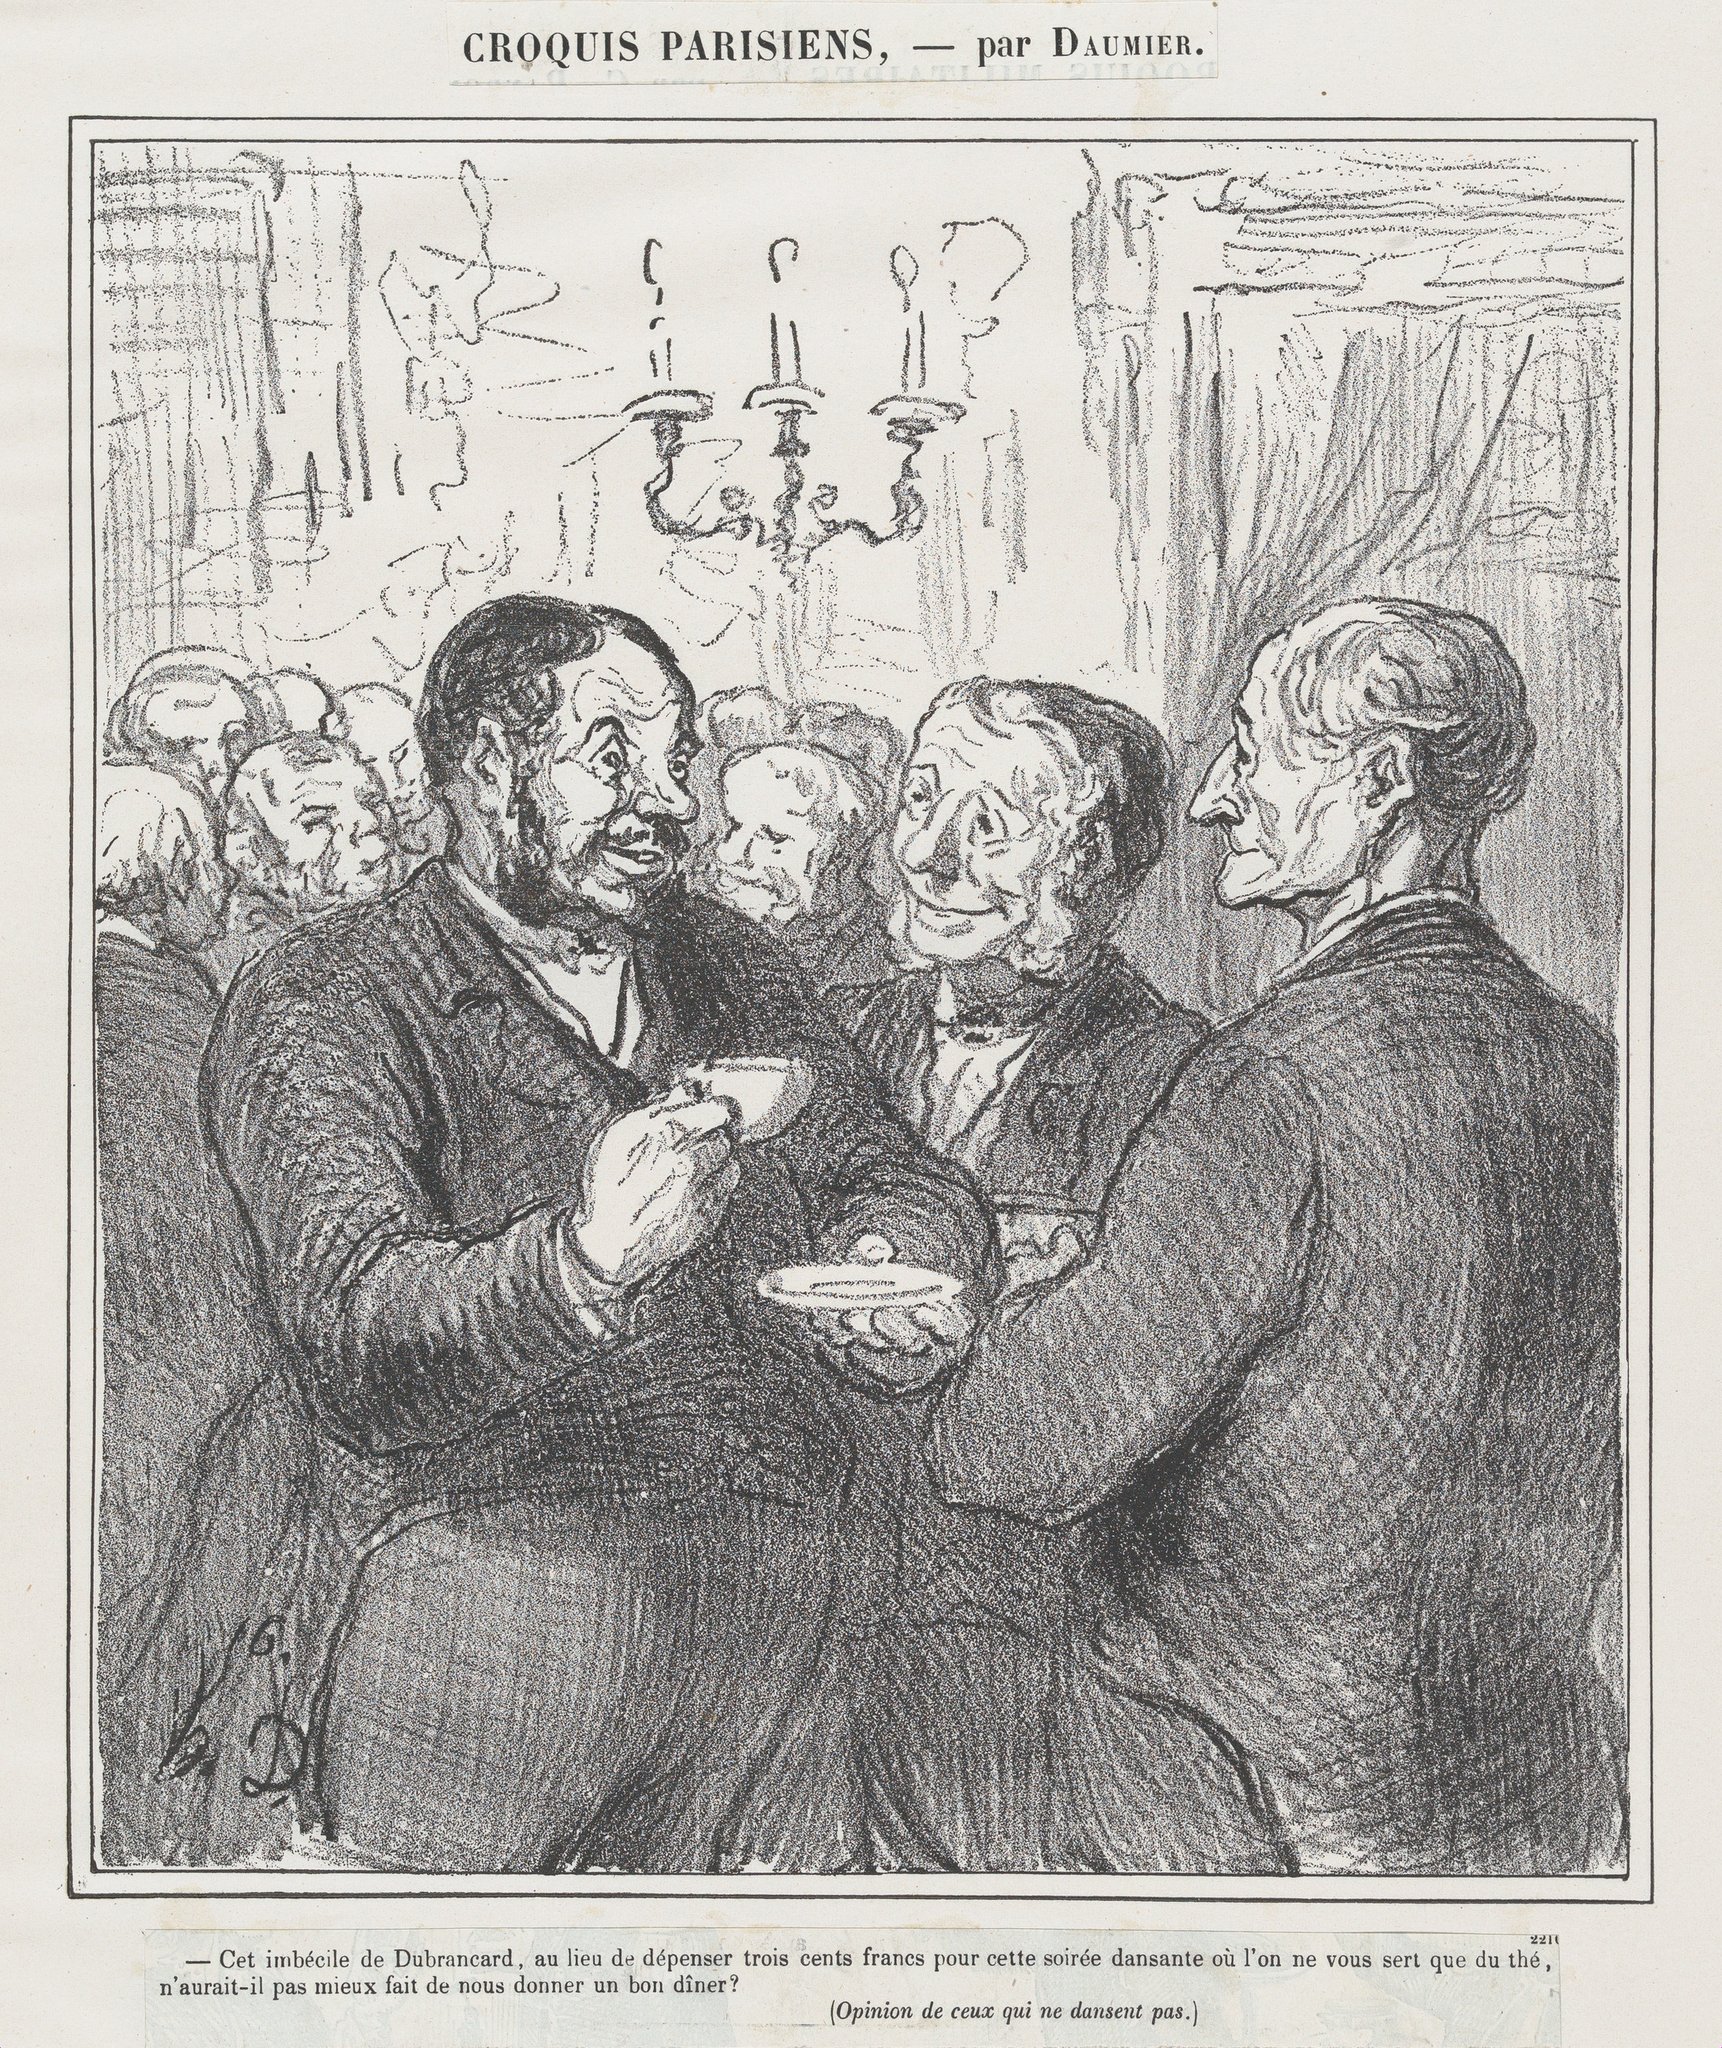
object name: print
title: This fool Dubrancard..., from 'Parisian sketches'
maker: honoré daumier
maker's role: artist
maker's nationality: french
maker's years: 1808-1879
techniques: lithograph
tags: men,tea drinking